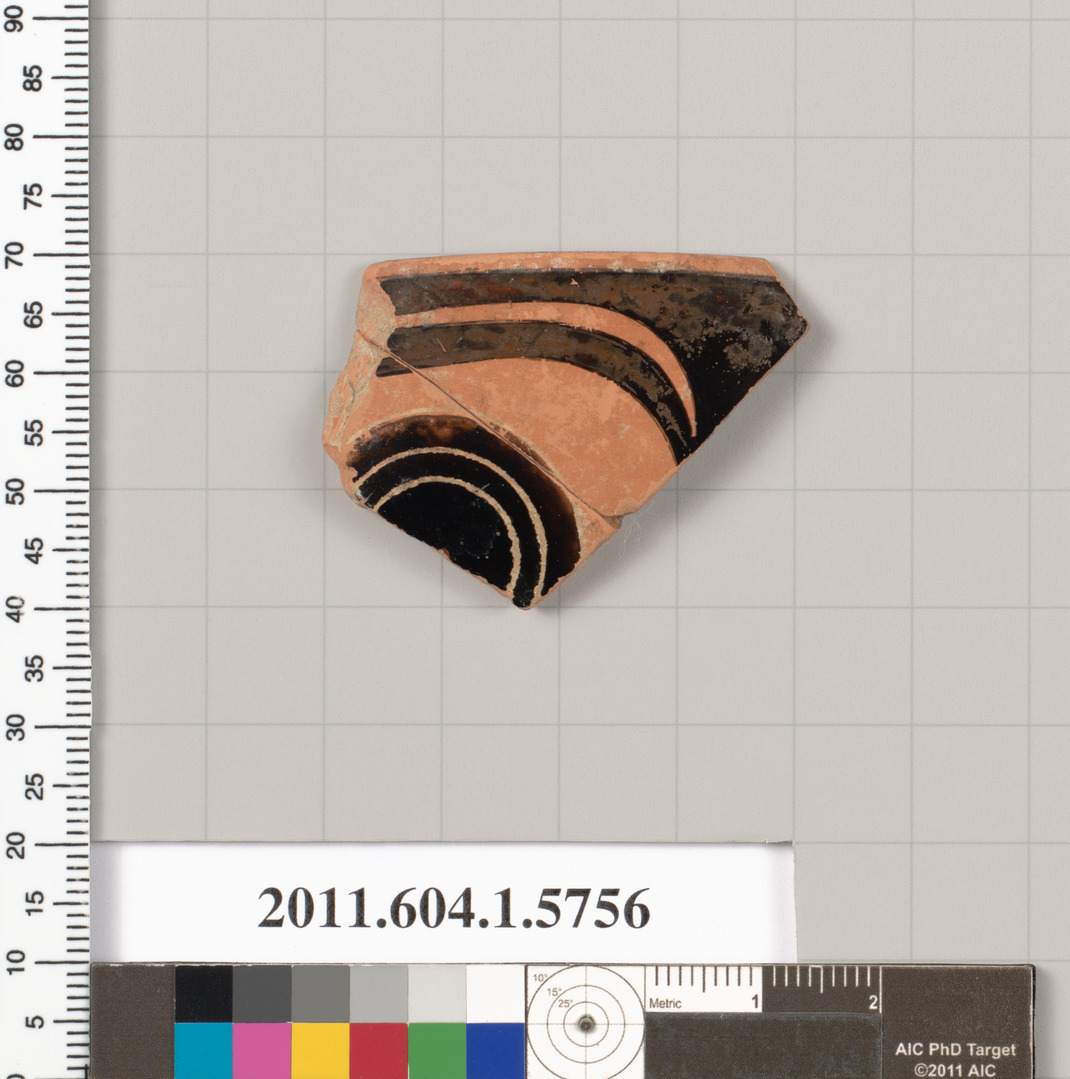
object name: kylix fragment, eye cup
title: Terracotta rim fragment of a kylix: eye-cup (drinking cup)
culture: greek, attic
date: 525-515 BCE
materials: terracotta